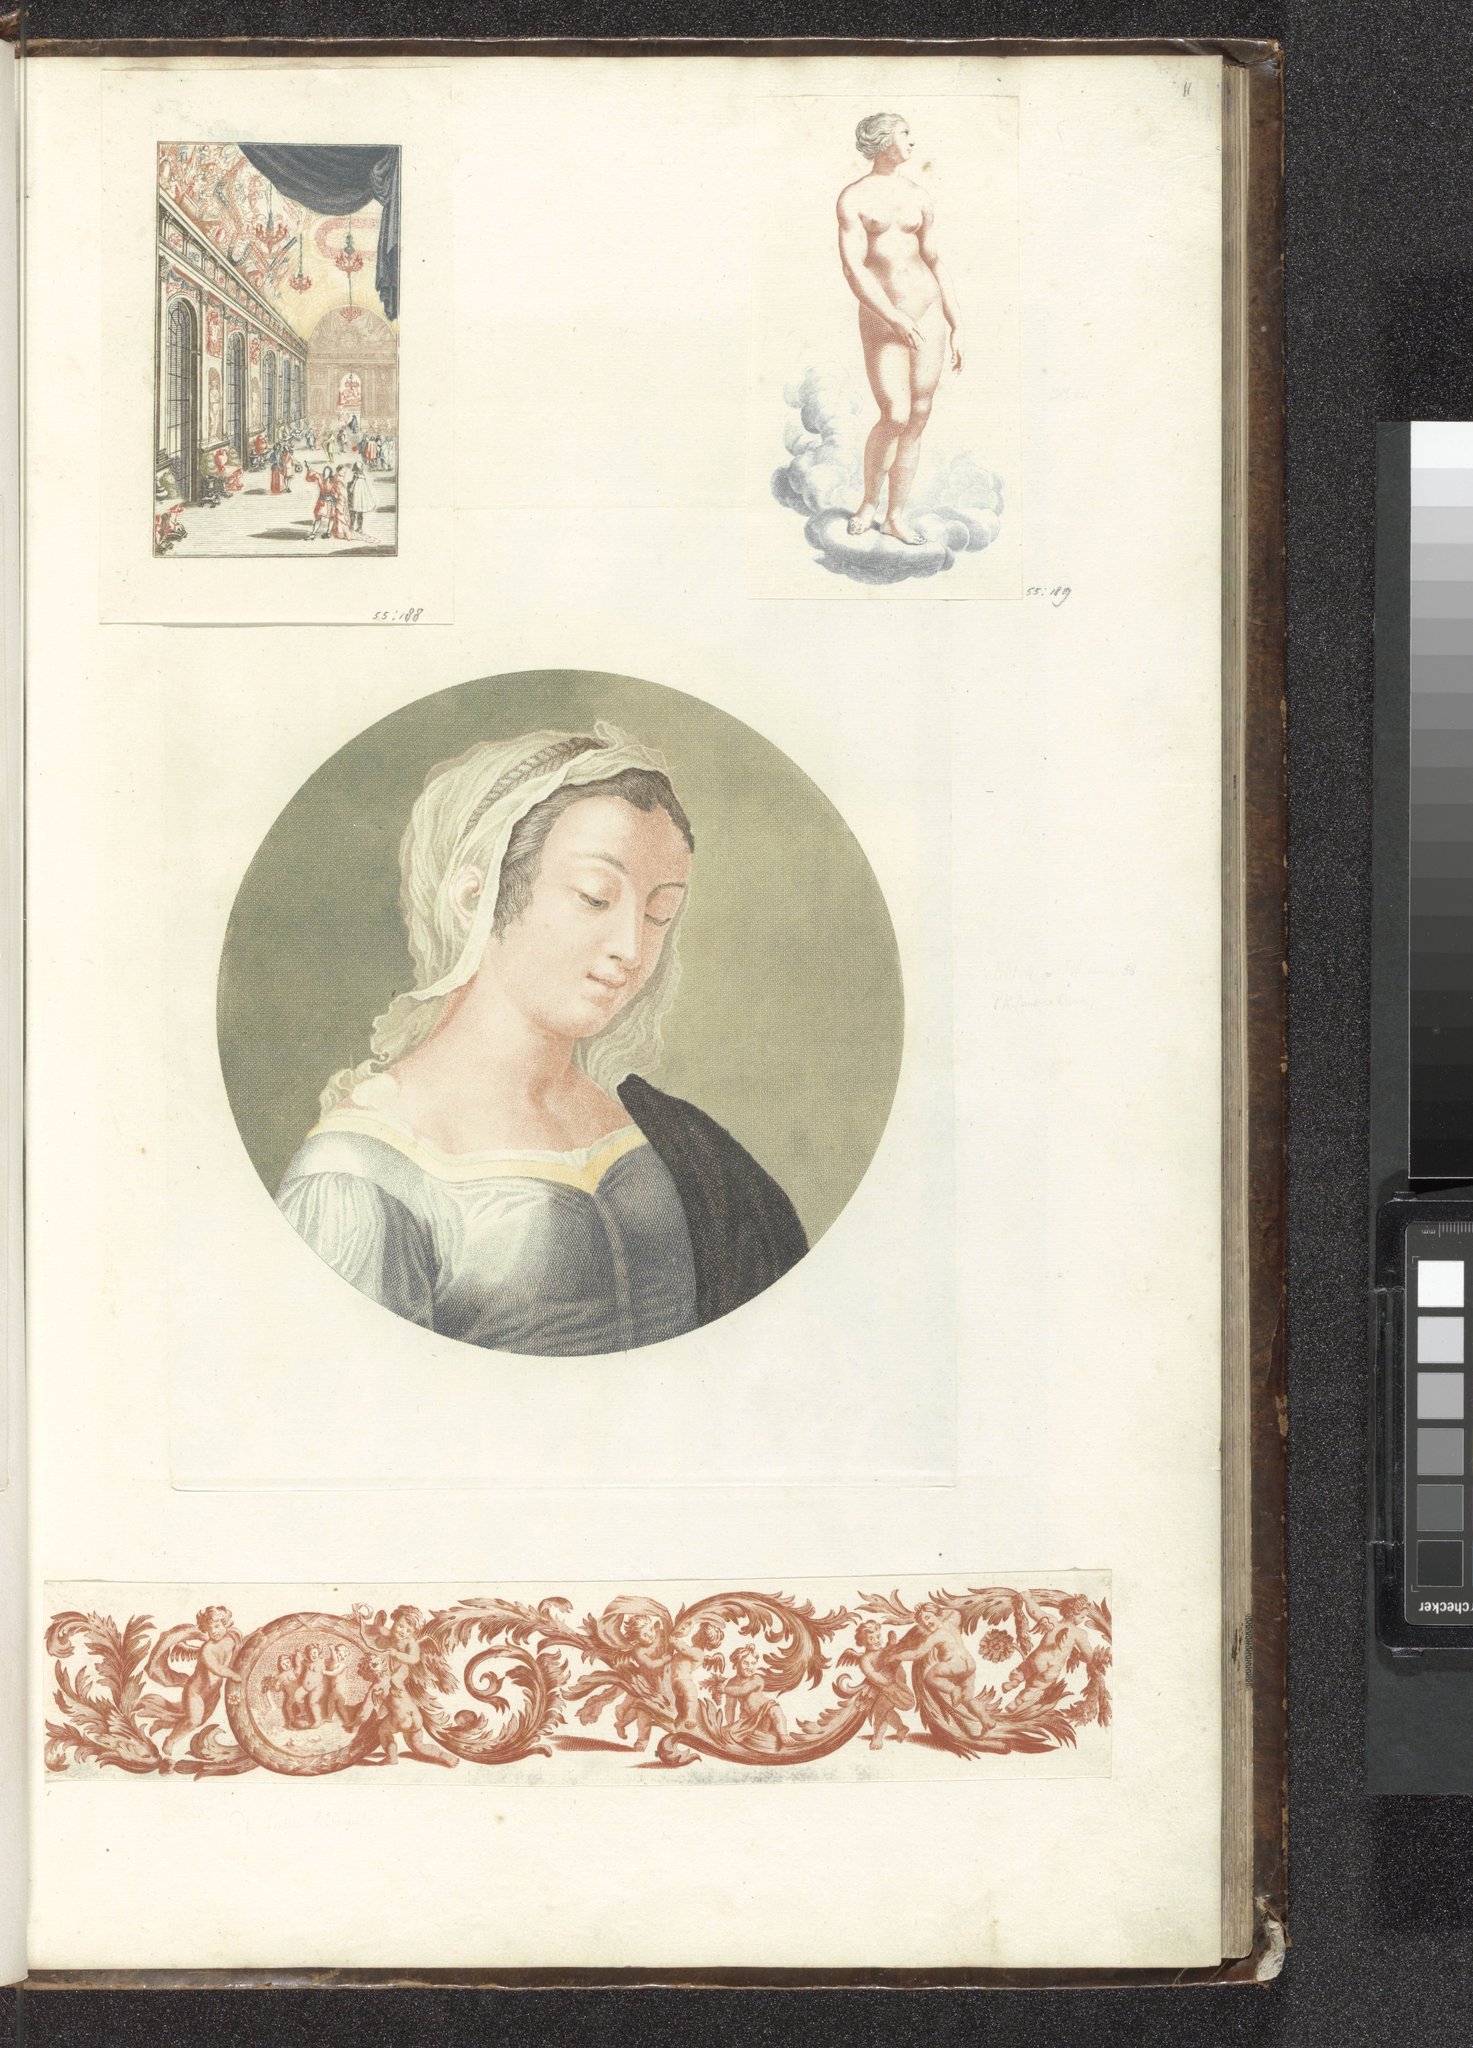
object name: album leaf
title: Spiegelzaal in het paleis van Versailles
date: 1688-1698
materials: paper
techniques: engraving, etching, lithography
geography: netherlands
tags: palace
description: De spiegelzaal (Galerie des Glaces) in het paleis van Versailles. Deze prent maakt deel uit van een album.